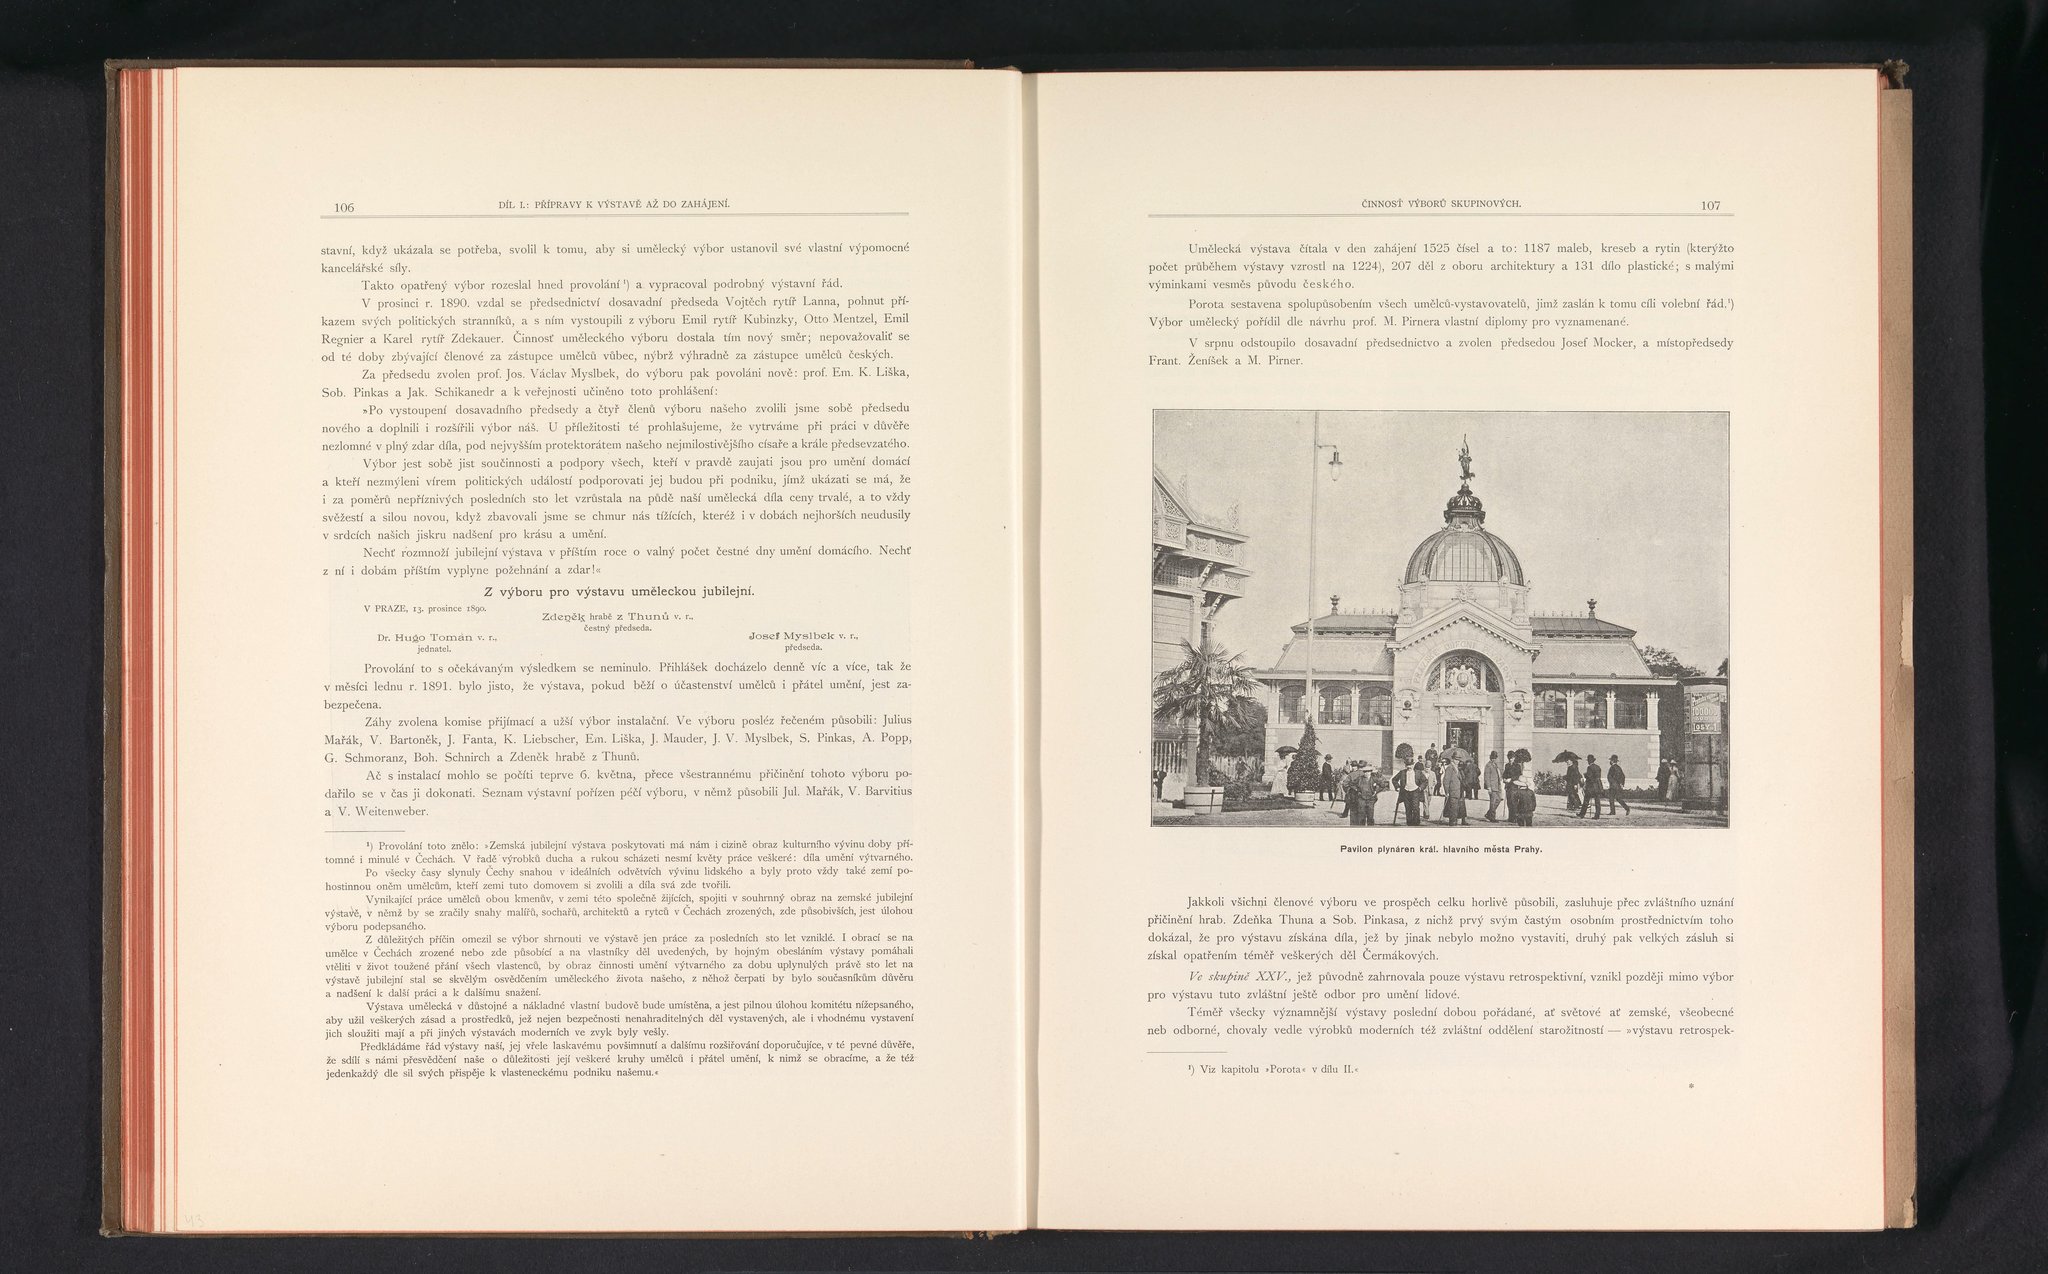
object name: photomechanical print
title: Exterieur van het koninklijk paviljoen op het Výstaviště te Praag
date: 1888-1893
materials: paper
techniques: autotype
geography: prague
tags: façade (of house or building), temporary exhibition, 'salon'